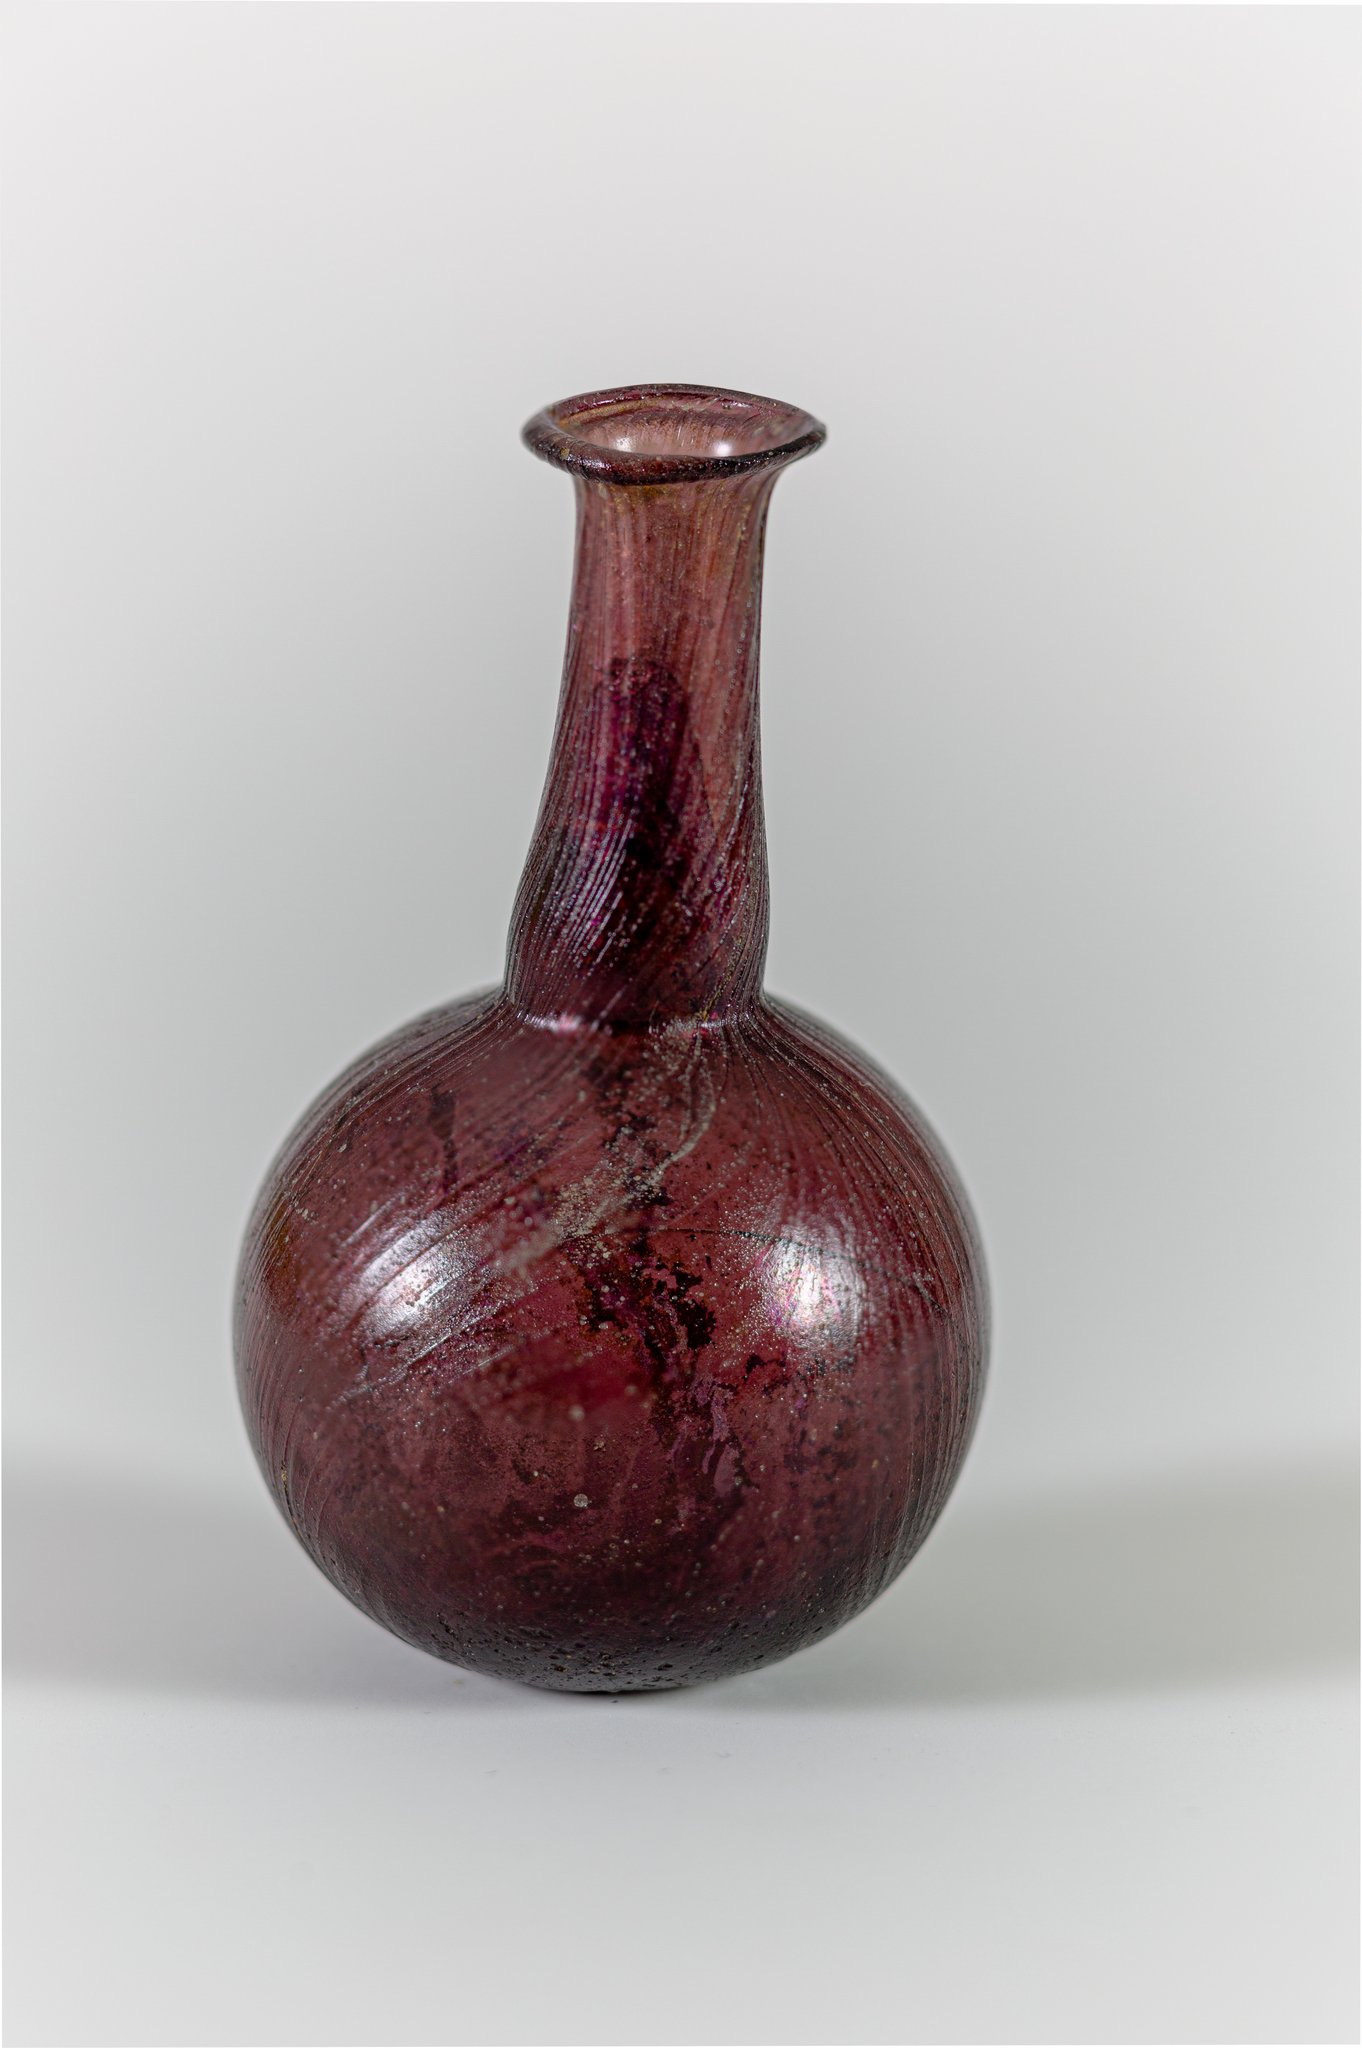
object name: perfume bottle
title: Glass perfume bottle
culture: roman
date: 1-100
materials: glass